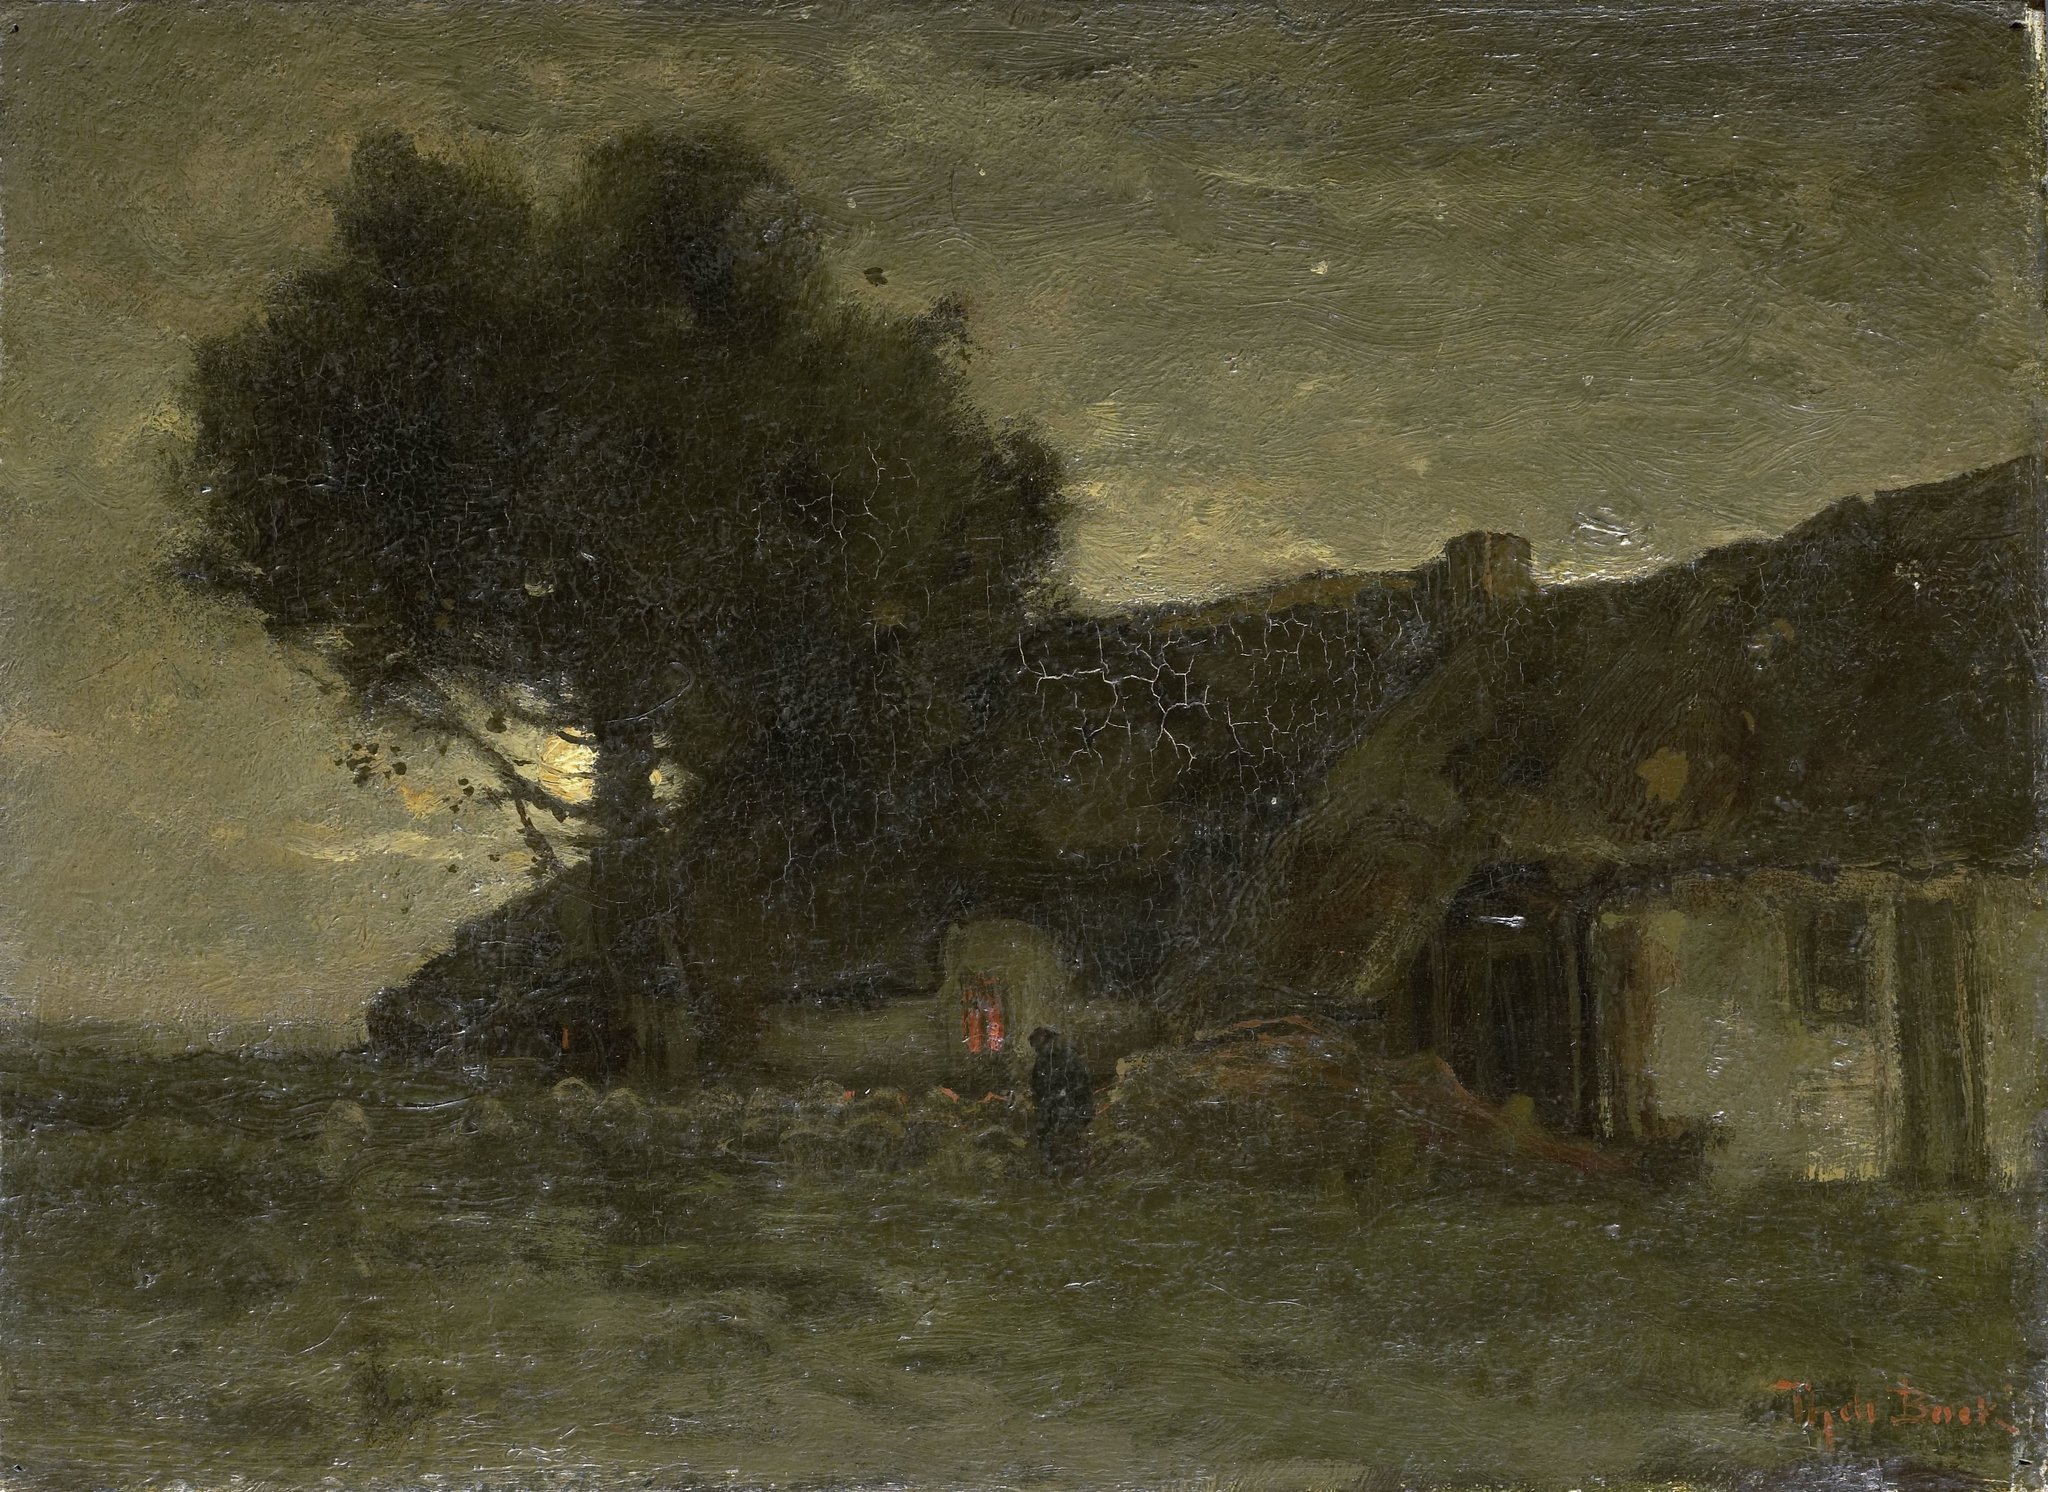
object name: painting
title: A Sheepfold at Nightfall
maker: théophile de bock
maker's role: draughtsman, painter, print maker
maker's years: 1851-1904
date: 1870-1904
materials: oil, panel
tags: sheep, shed, stall, stable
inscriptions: signature: ‘Th. de Bock’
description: Een schaapskooi bij avondlicht. Een kudde schapen verzameld voor een boerderij.